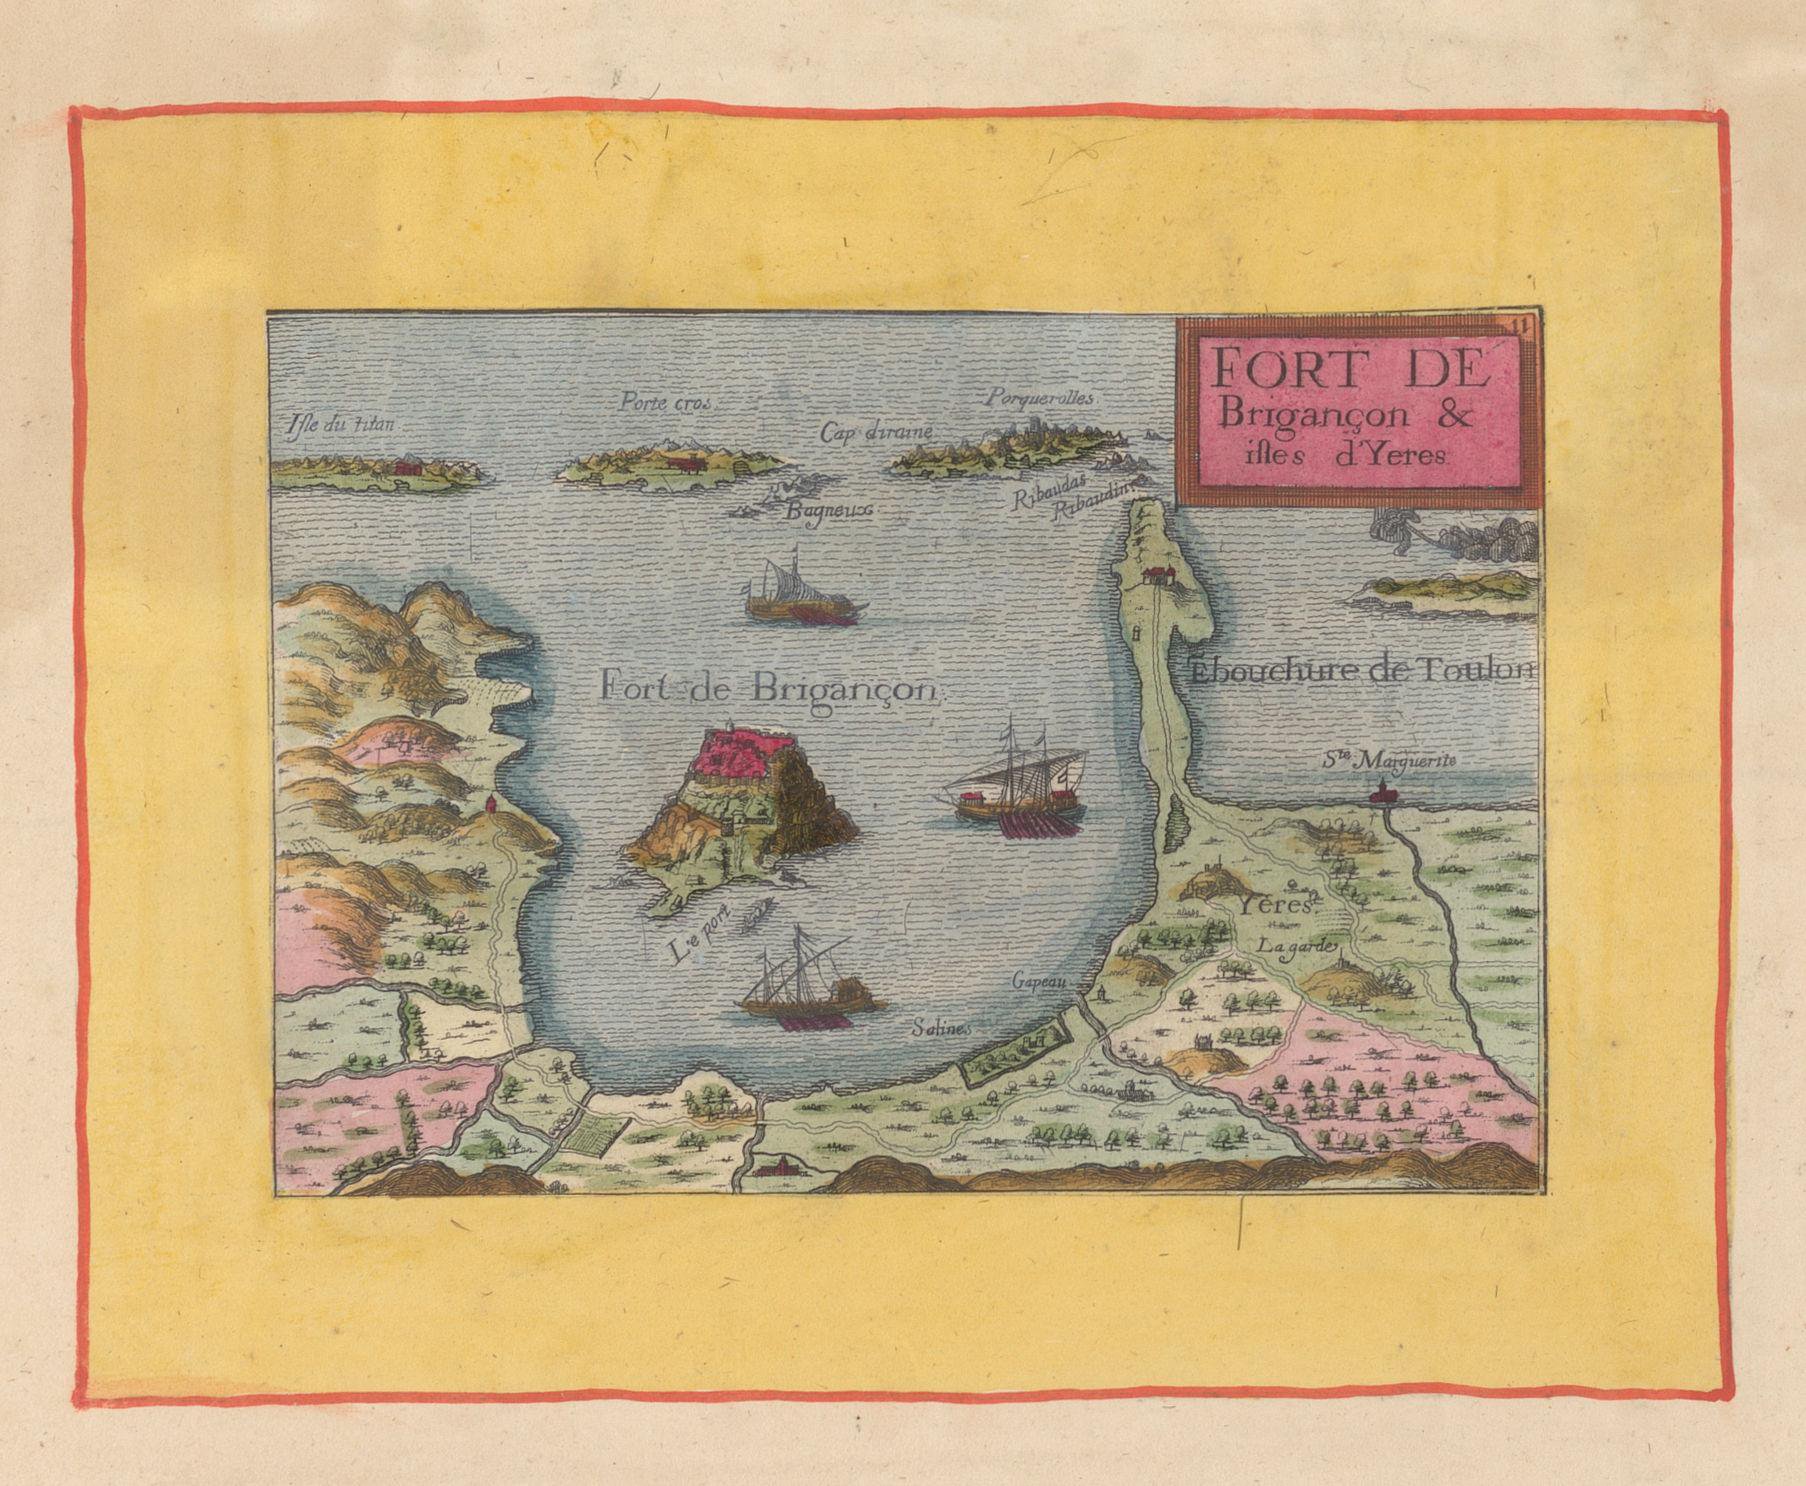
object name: map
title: Fort de Brigançon & isles d'Yeres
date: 1638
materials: paper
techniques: engraving, etching, hand coloring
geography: the hague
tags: fortress, maps of separate countries or regions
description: Prent uit: Tassin, Christophe. Les plans et profils de toutes les principales villes et lieux considérables de France (...). Parijs: Michel van Lochom, 1638, prent 11 uit het deel 'Provence'.